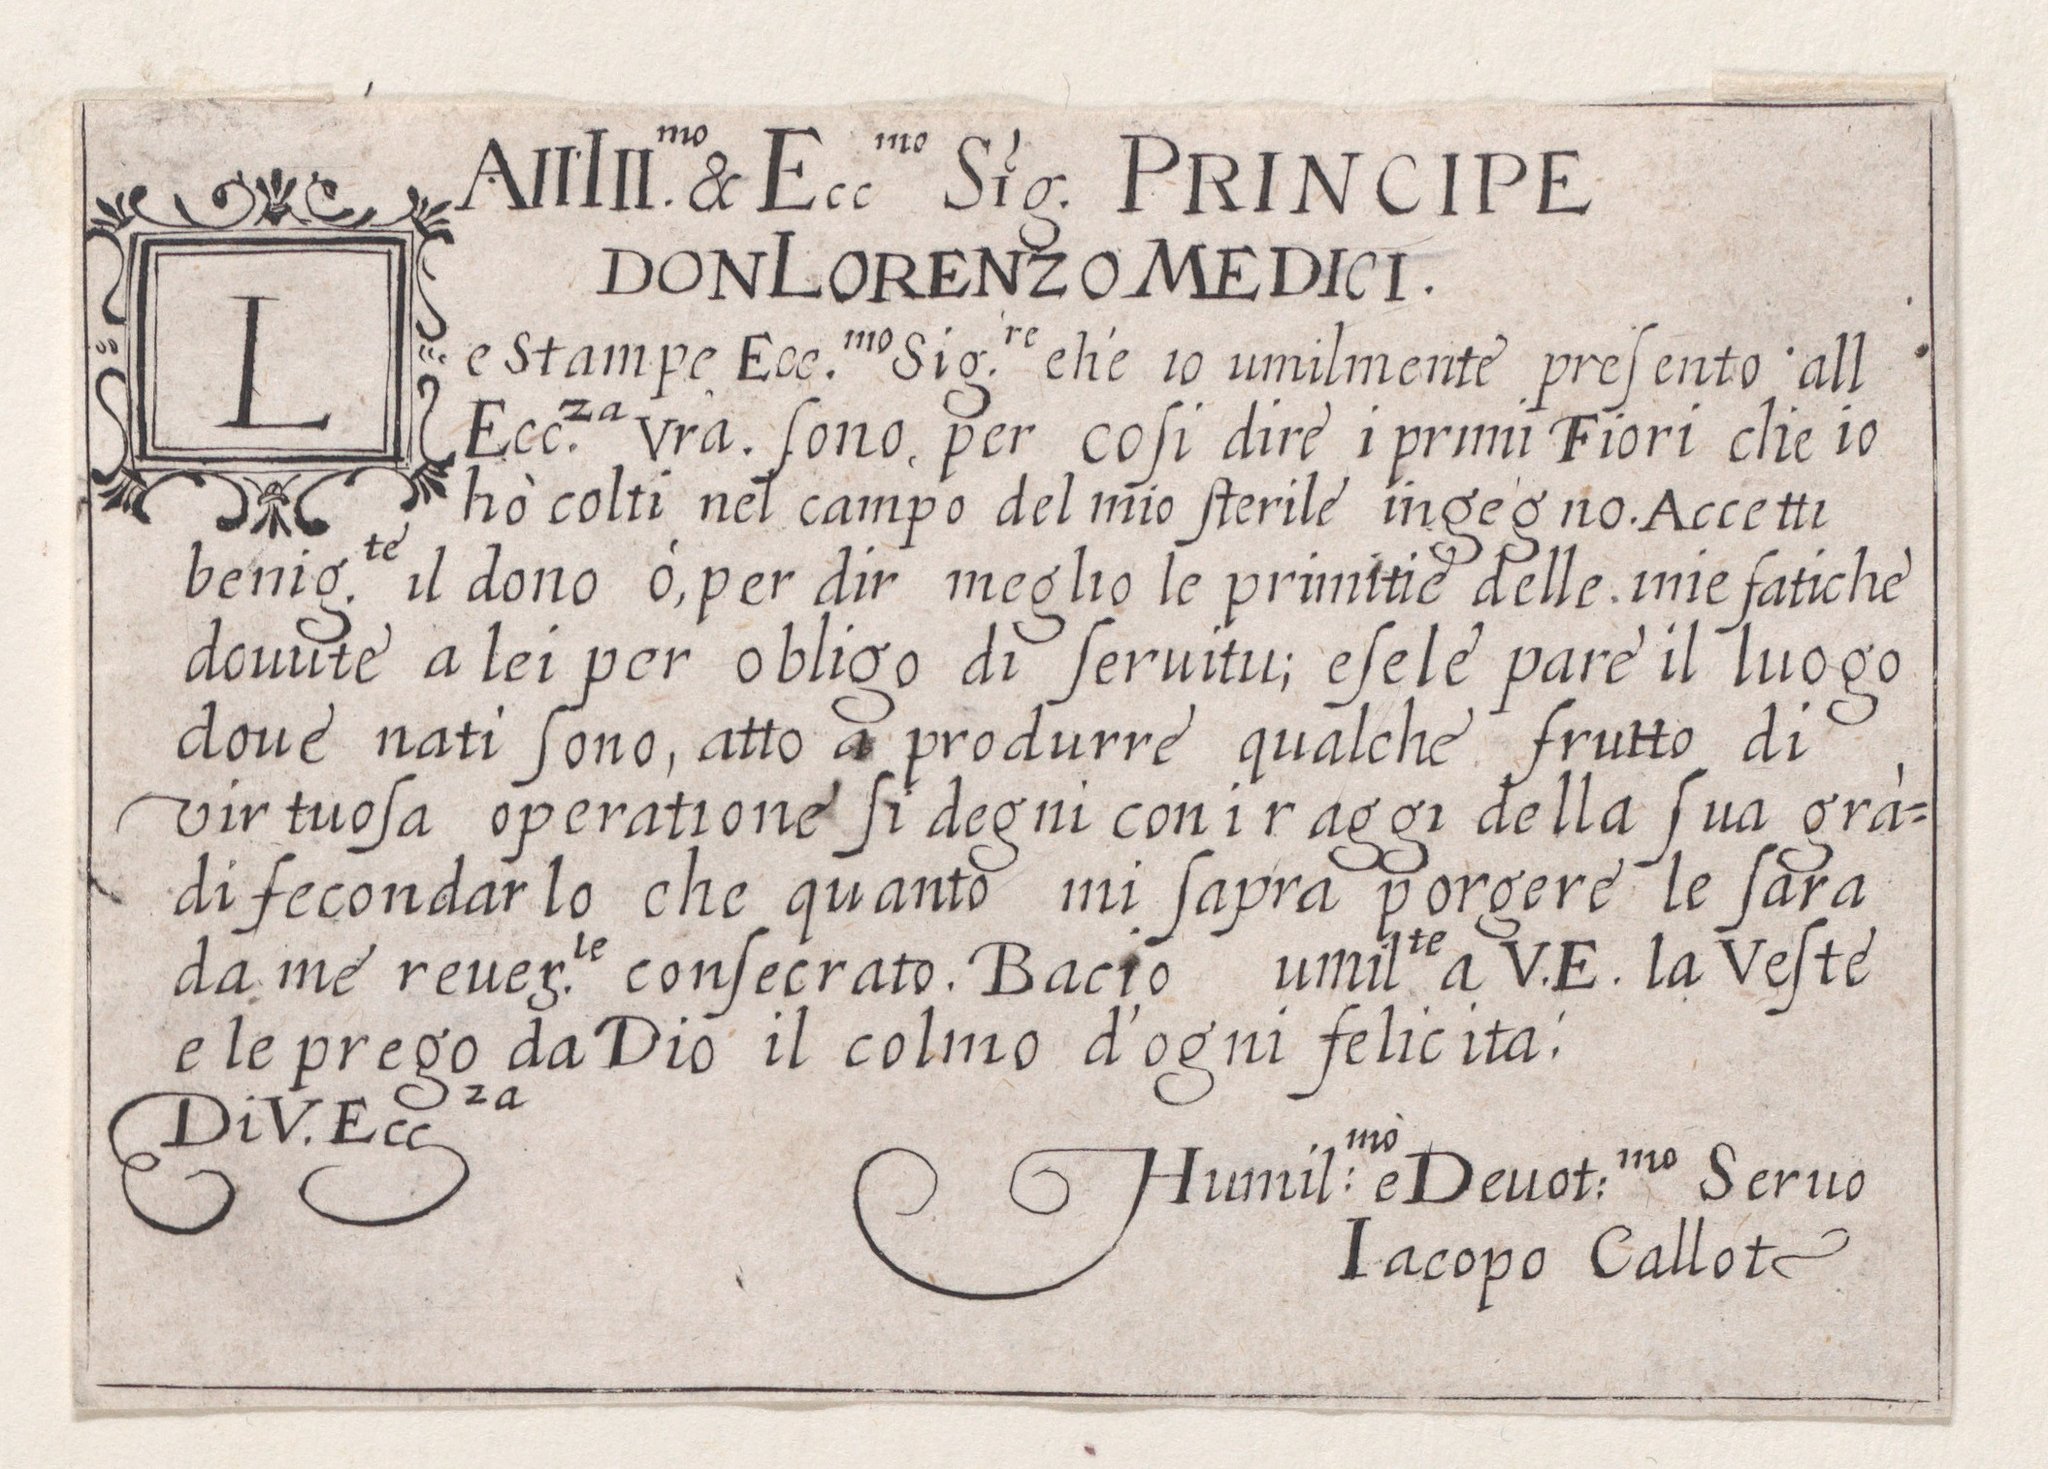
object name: print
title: Copy of Dedication to Lorenzo de'Medici, from "Les Caprices" Series A, The Florence Set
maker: Anonymous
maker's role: artist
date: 1601-1700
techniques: etching